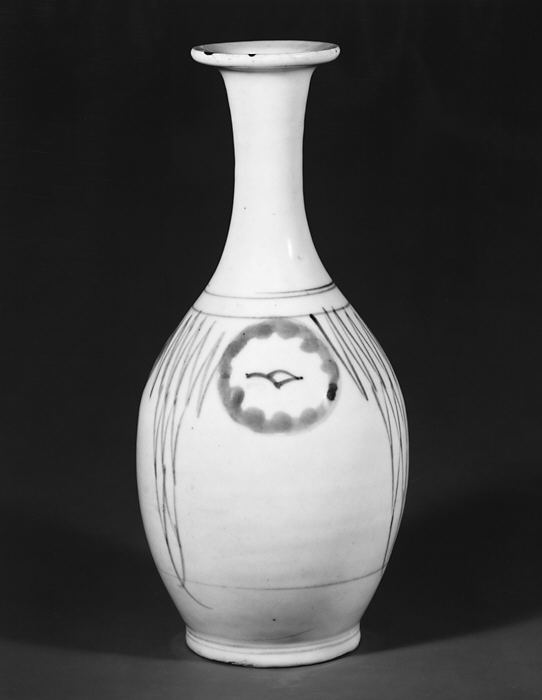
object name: wine bottle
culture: japanese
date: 1624-1643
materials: porcelain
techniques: painting, underglaze